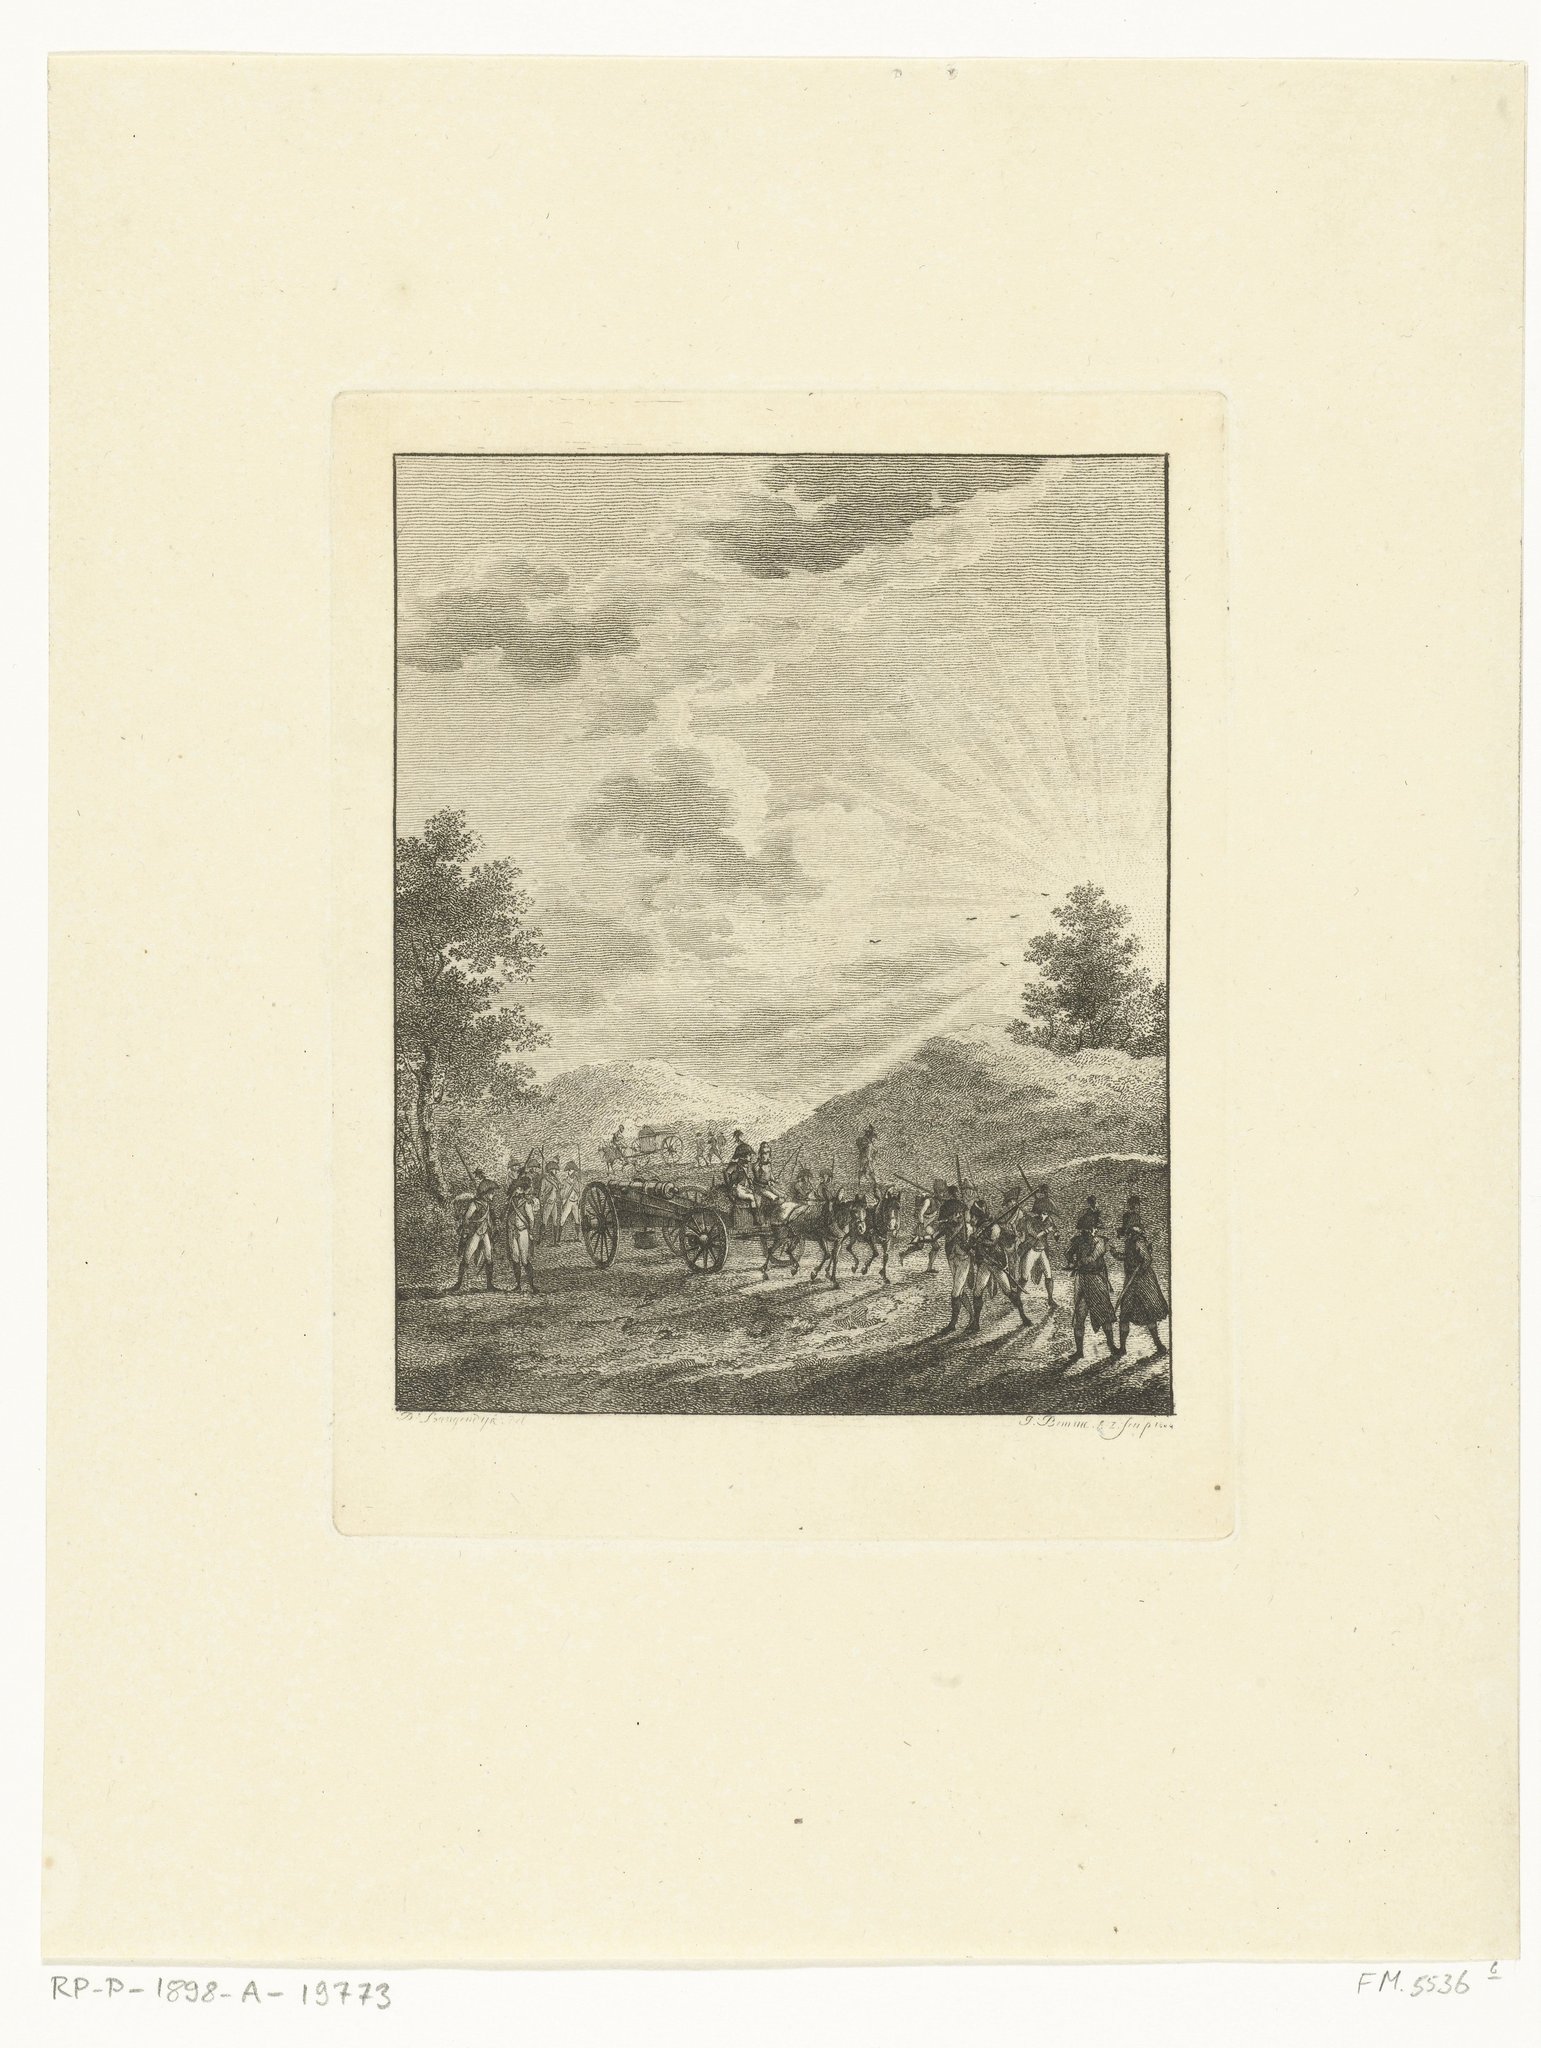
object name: print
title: Infanteristen in een zonovergoten landschap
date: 1804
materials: paper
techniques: etching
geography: rotterdam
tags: warfare; military affairs (+ infantry)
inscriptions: collector's mark: Lugt 2228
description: Infanteristen lopen in een zonovergoten landschap. Tussen hen in wagens met kanonnen en munitie.